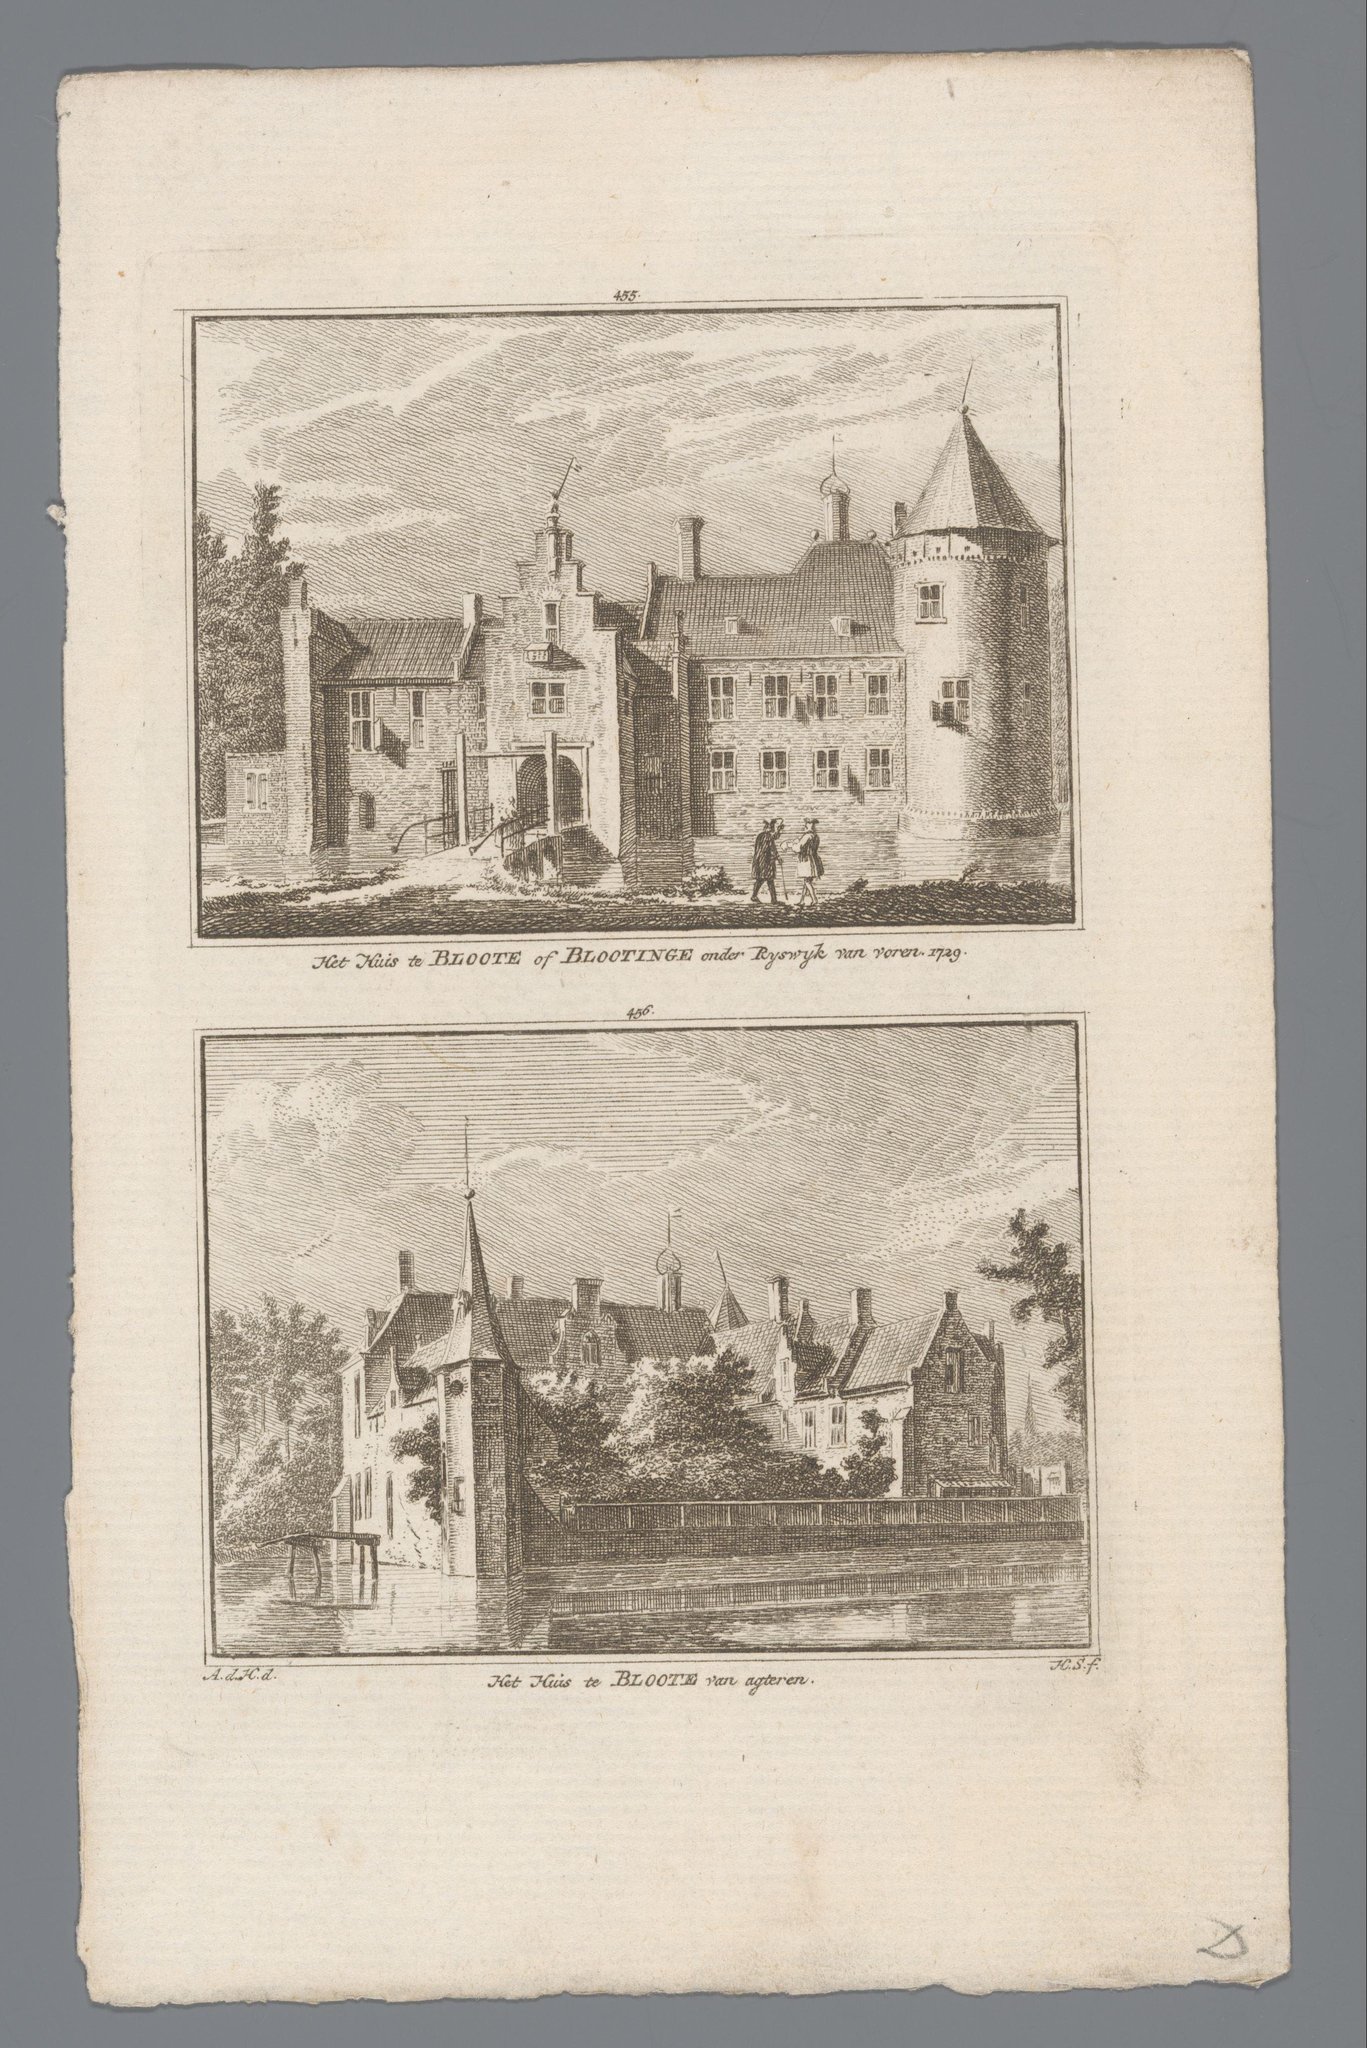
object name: print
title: Gezichten op de voor- en achterzijde van Huis Te Blotinghe bij Rijswijk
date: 1757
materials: paper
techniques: engraving, etching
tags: farm or solitary house in landscape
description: Prent uit: Spilman, Hendrik. Het verheerlykt Nederland, of kabinet van hedendaagsche gezigten. 9 dln. Amsterdam: Isaac Tirion, 1745-1774, dl. 6, nr. 455-456.